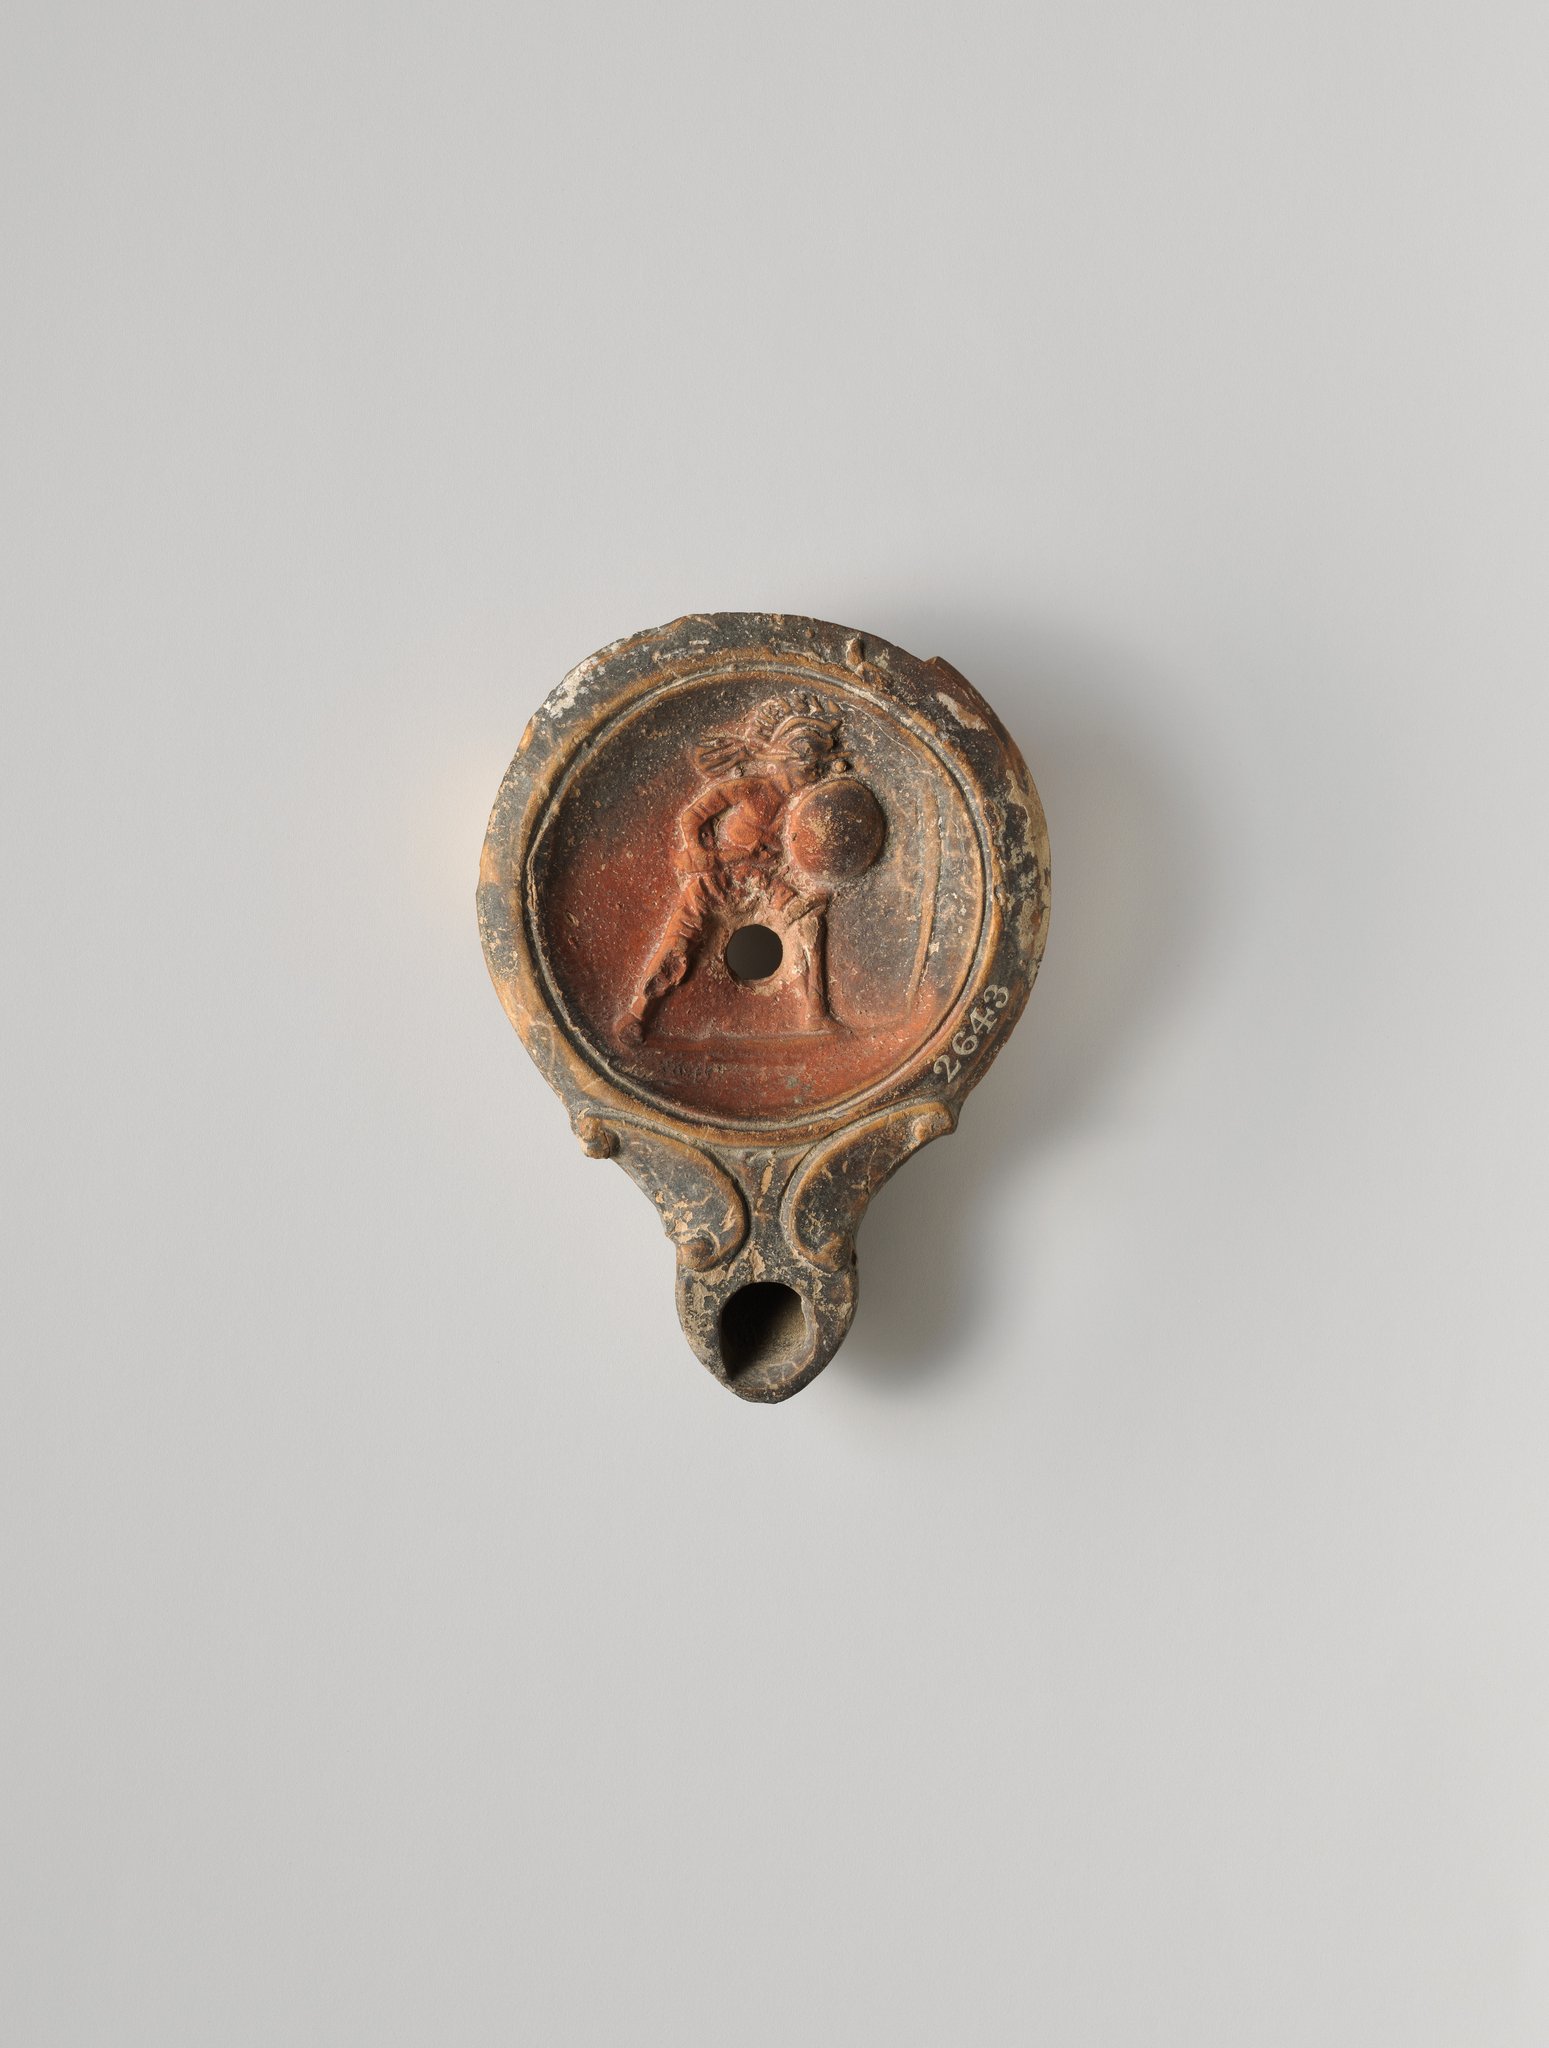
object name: lamp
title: Terracotta oil lamp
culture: roman, cypriot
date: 50-100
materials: terracotta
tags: shields,men,gladiators